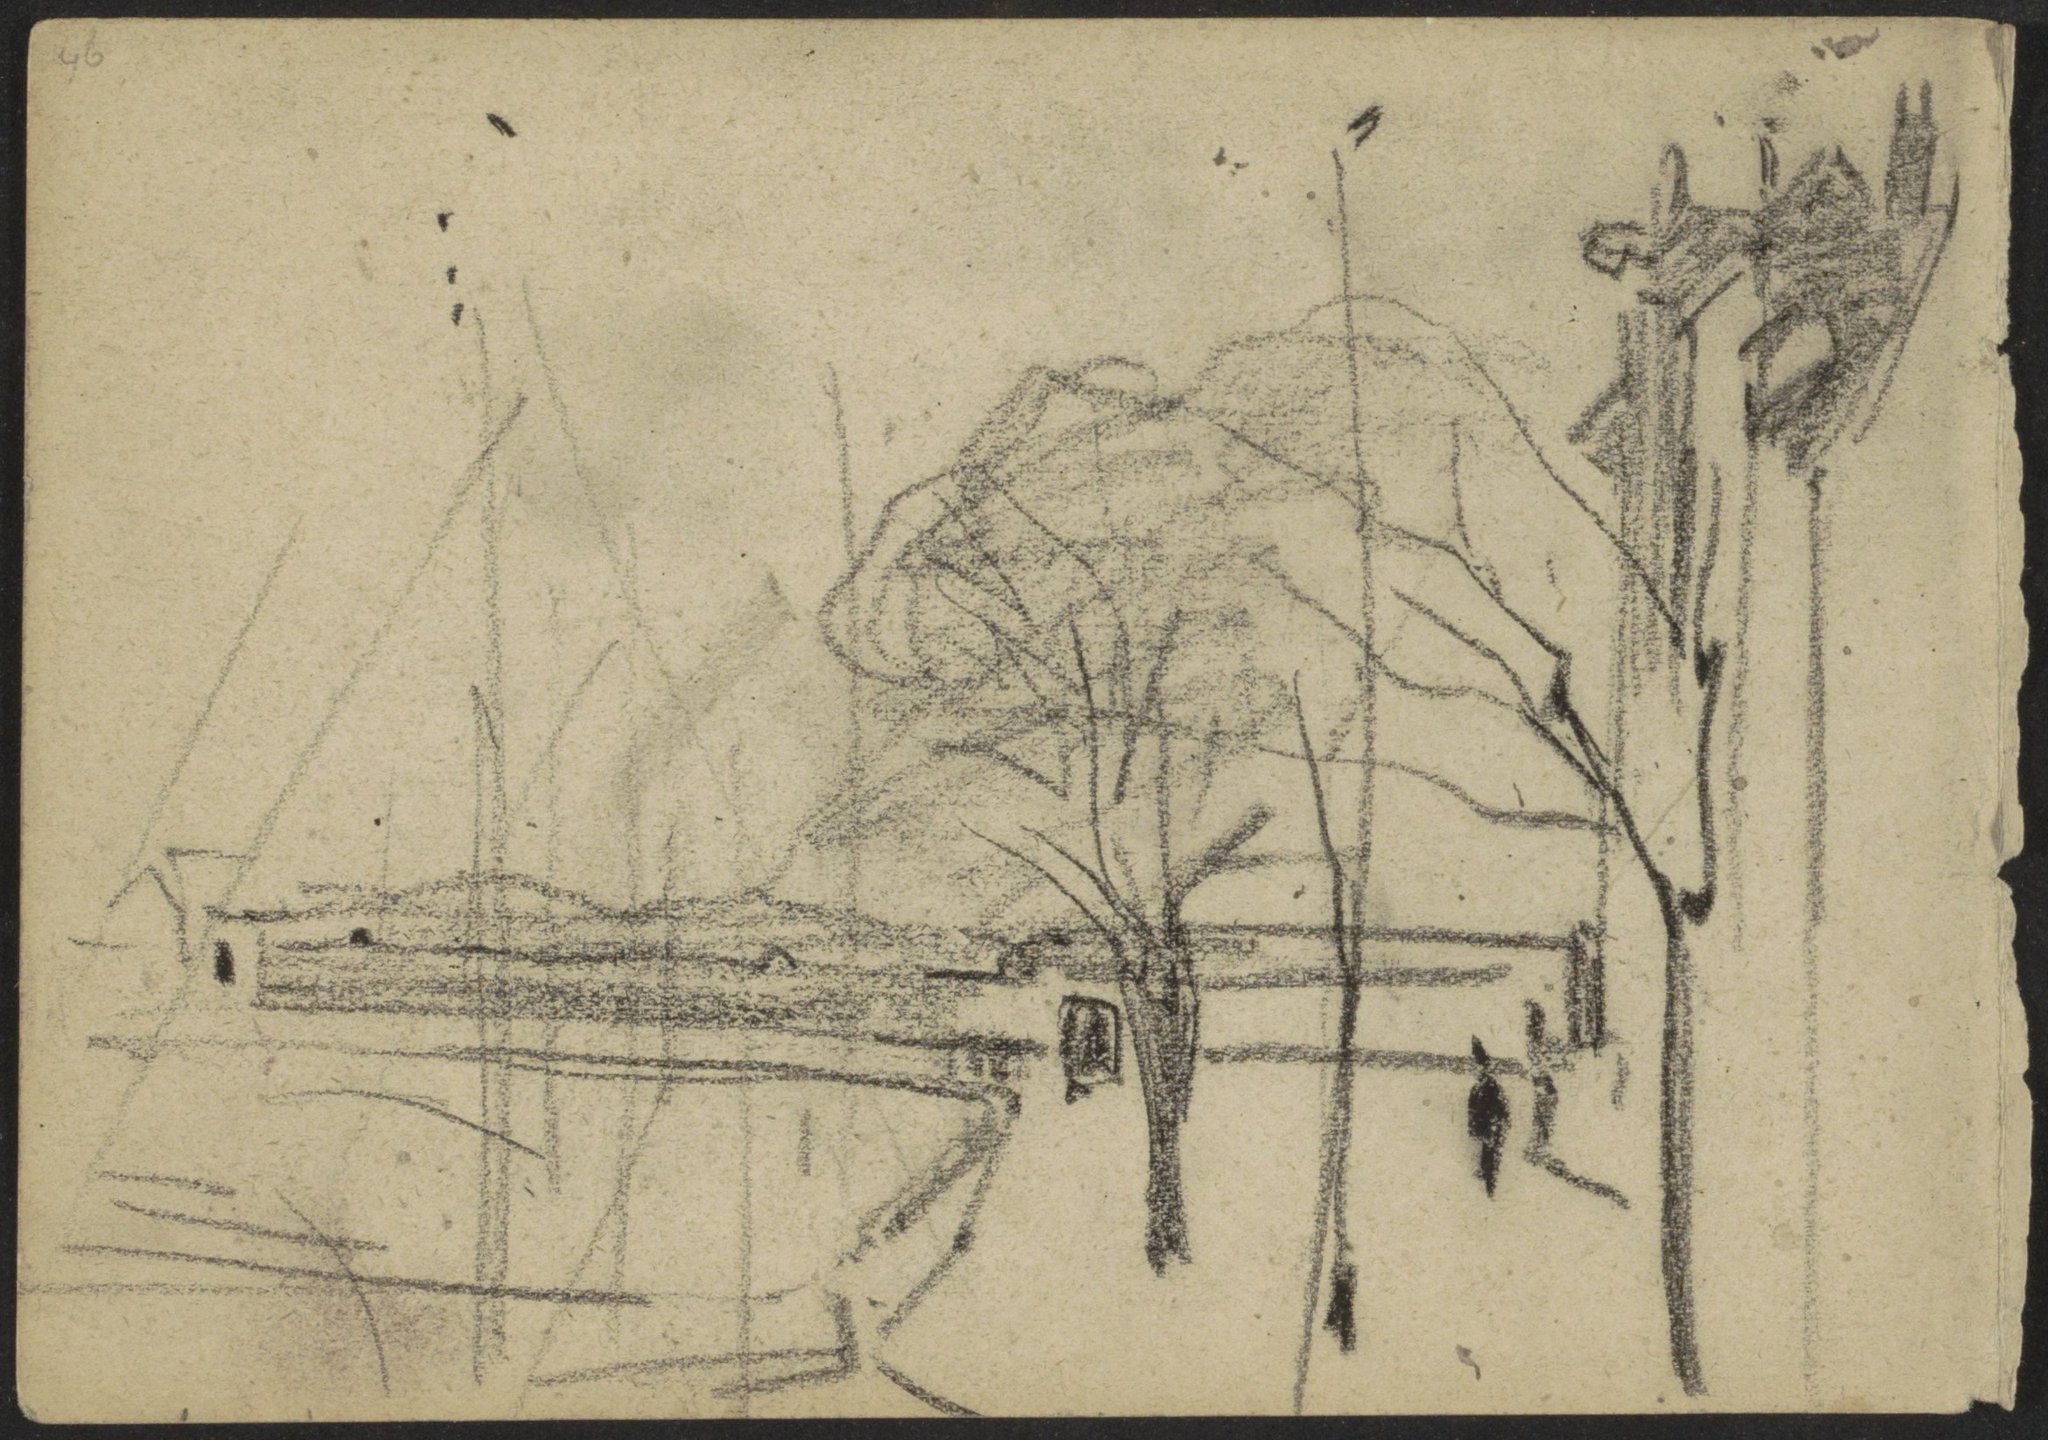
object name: sketchbook leaf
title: Gezicht op een kade in Amsterdam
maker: willem witsen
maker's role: draughtsman, painter, print maker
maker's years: 1860-1923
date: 1870-1923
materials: chalk, paper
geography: amsterdam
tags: quay, amsterdam